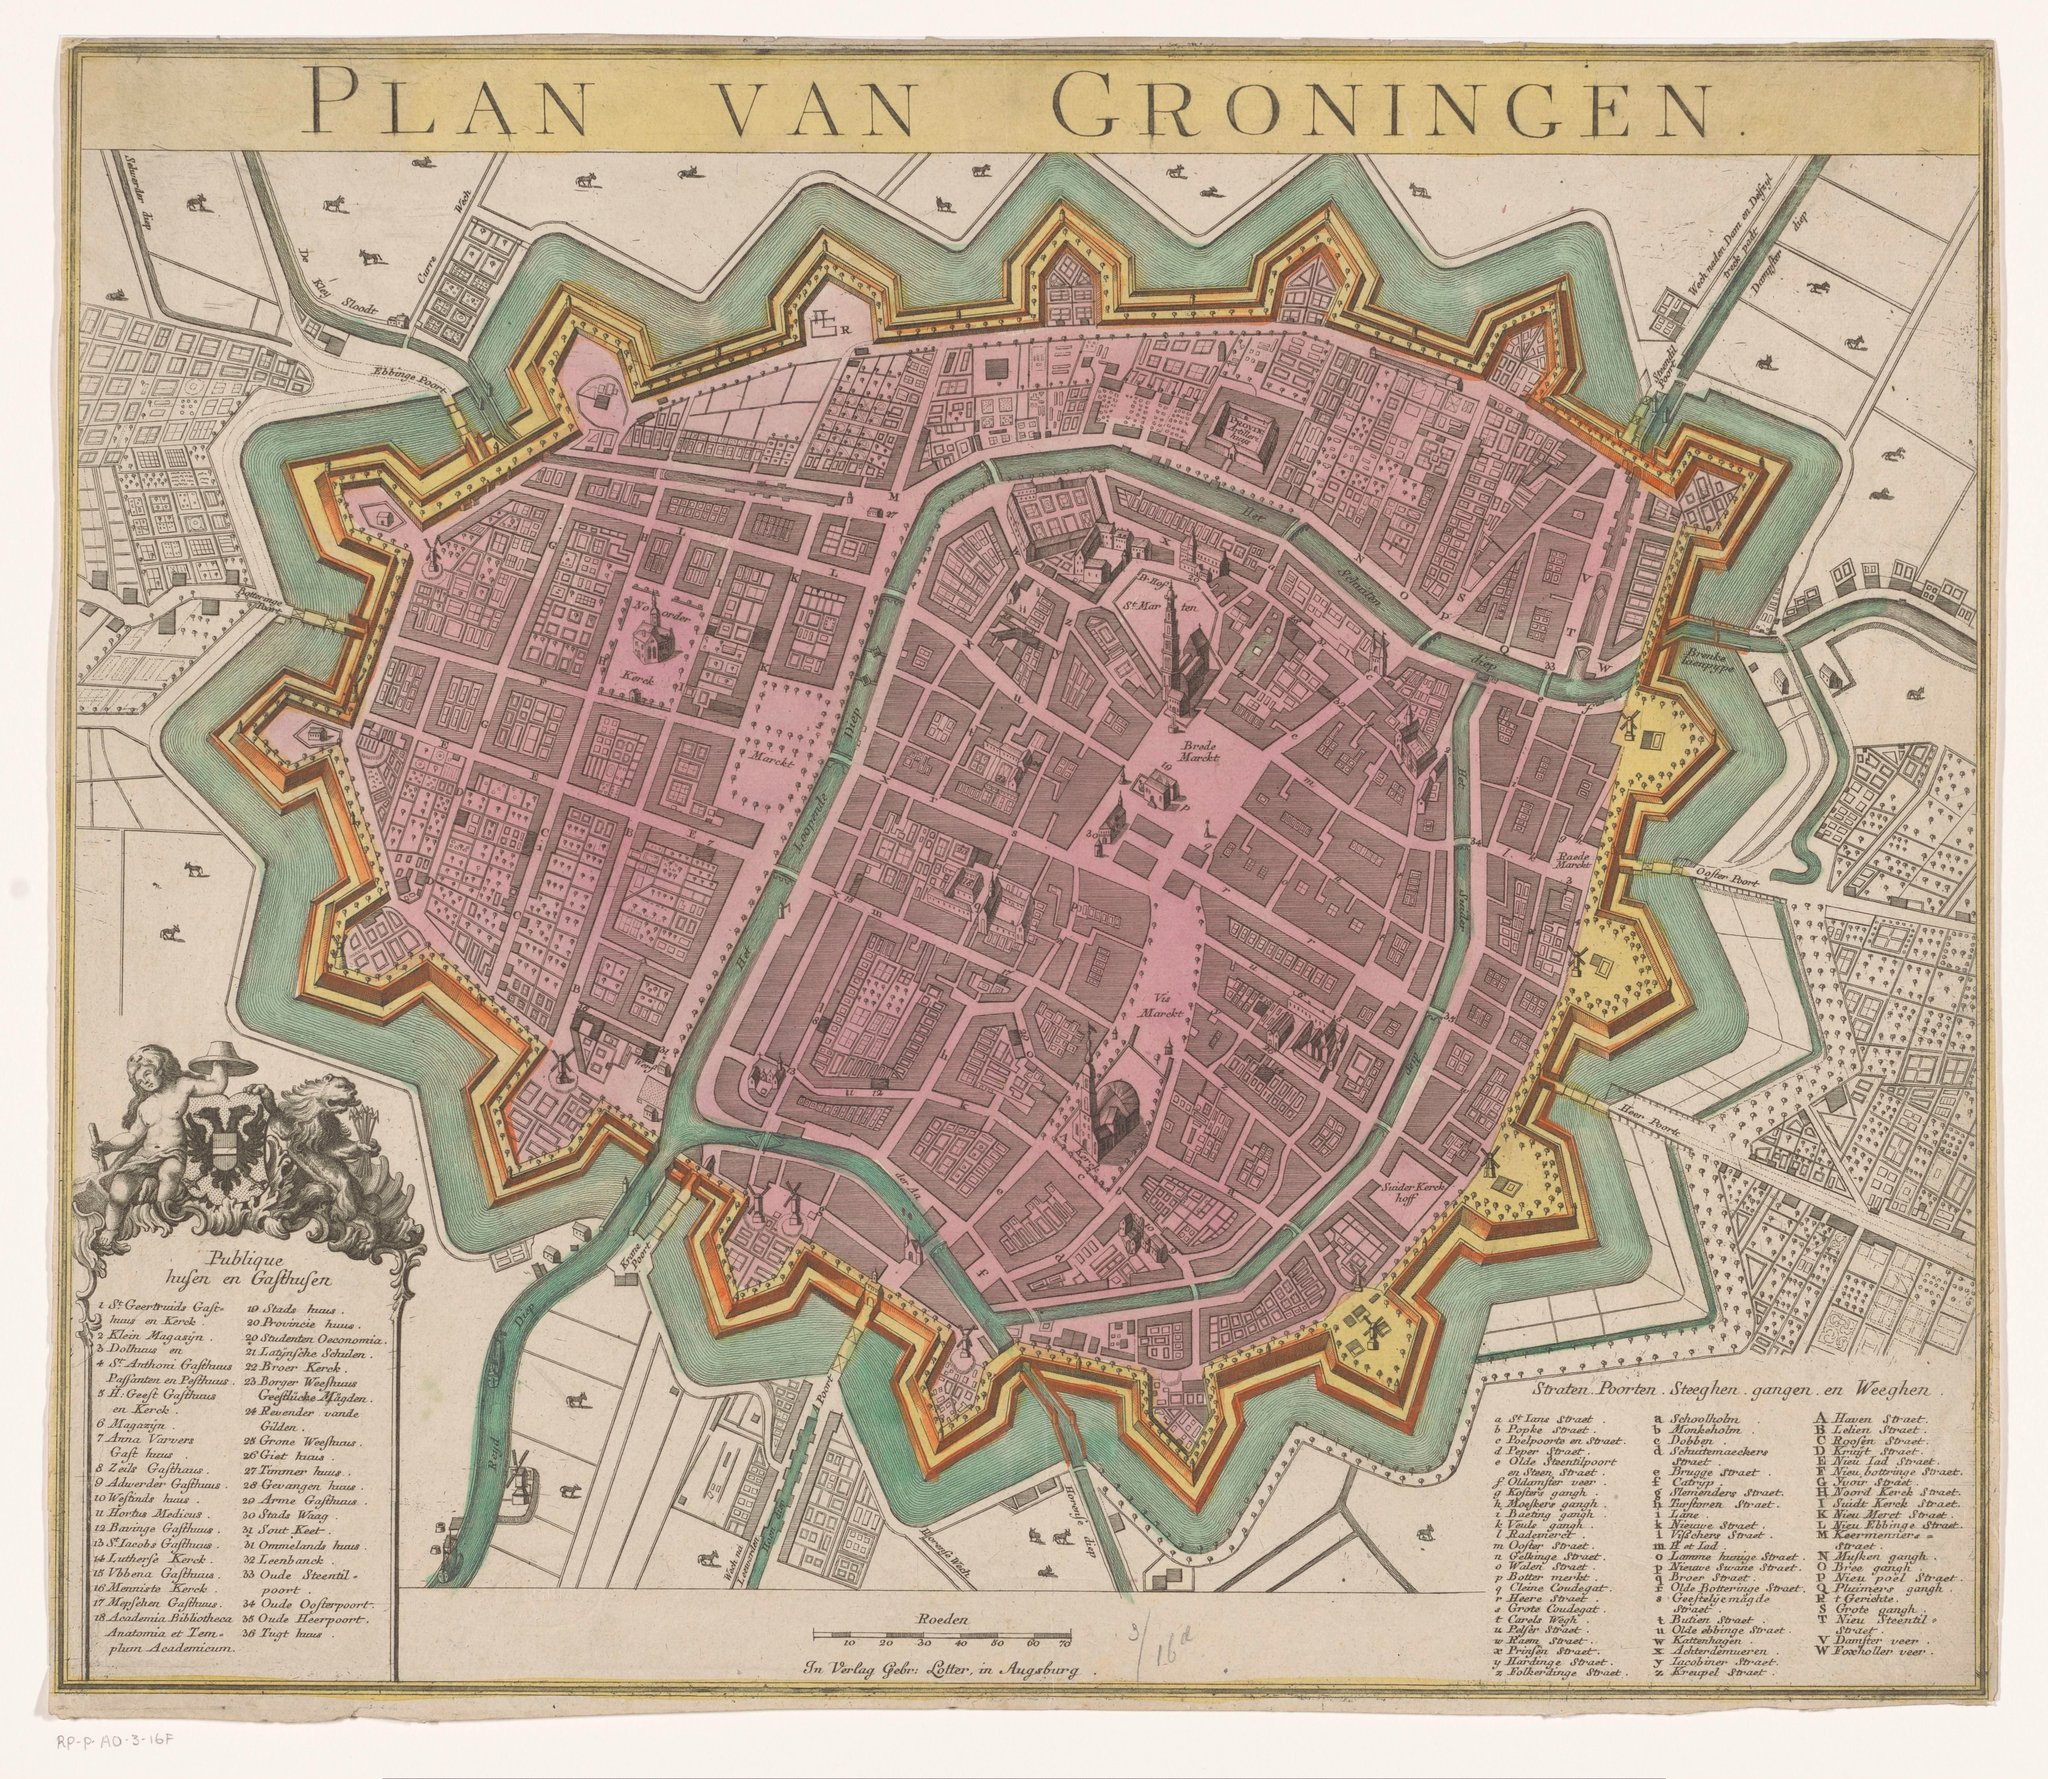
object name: print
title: Plan van Groningen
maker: Anonymous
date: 1743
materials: paper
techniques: engraving, etching, hand coloring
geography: augsburg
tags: coat of arms (as symbol of the state, etc.), maps of cities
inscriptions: collector's mark: Lugt 2228, check stamp: ‘Archief Ministerie van Oorlog Afdeeling Genie’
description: Plattegrond in vogelvluchtperspectief. Linksonder cartouche met legenda, het wapen van de stad Groningen een jongen met de vrijheidshoed en de Nederlandse Leeuw met pijlenbundel. Onderaan in het midden een schaalstok: Roeden. Rechtsonder nog een legenda.